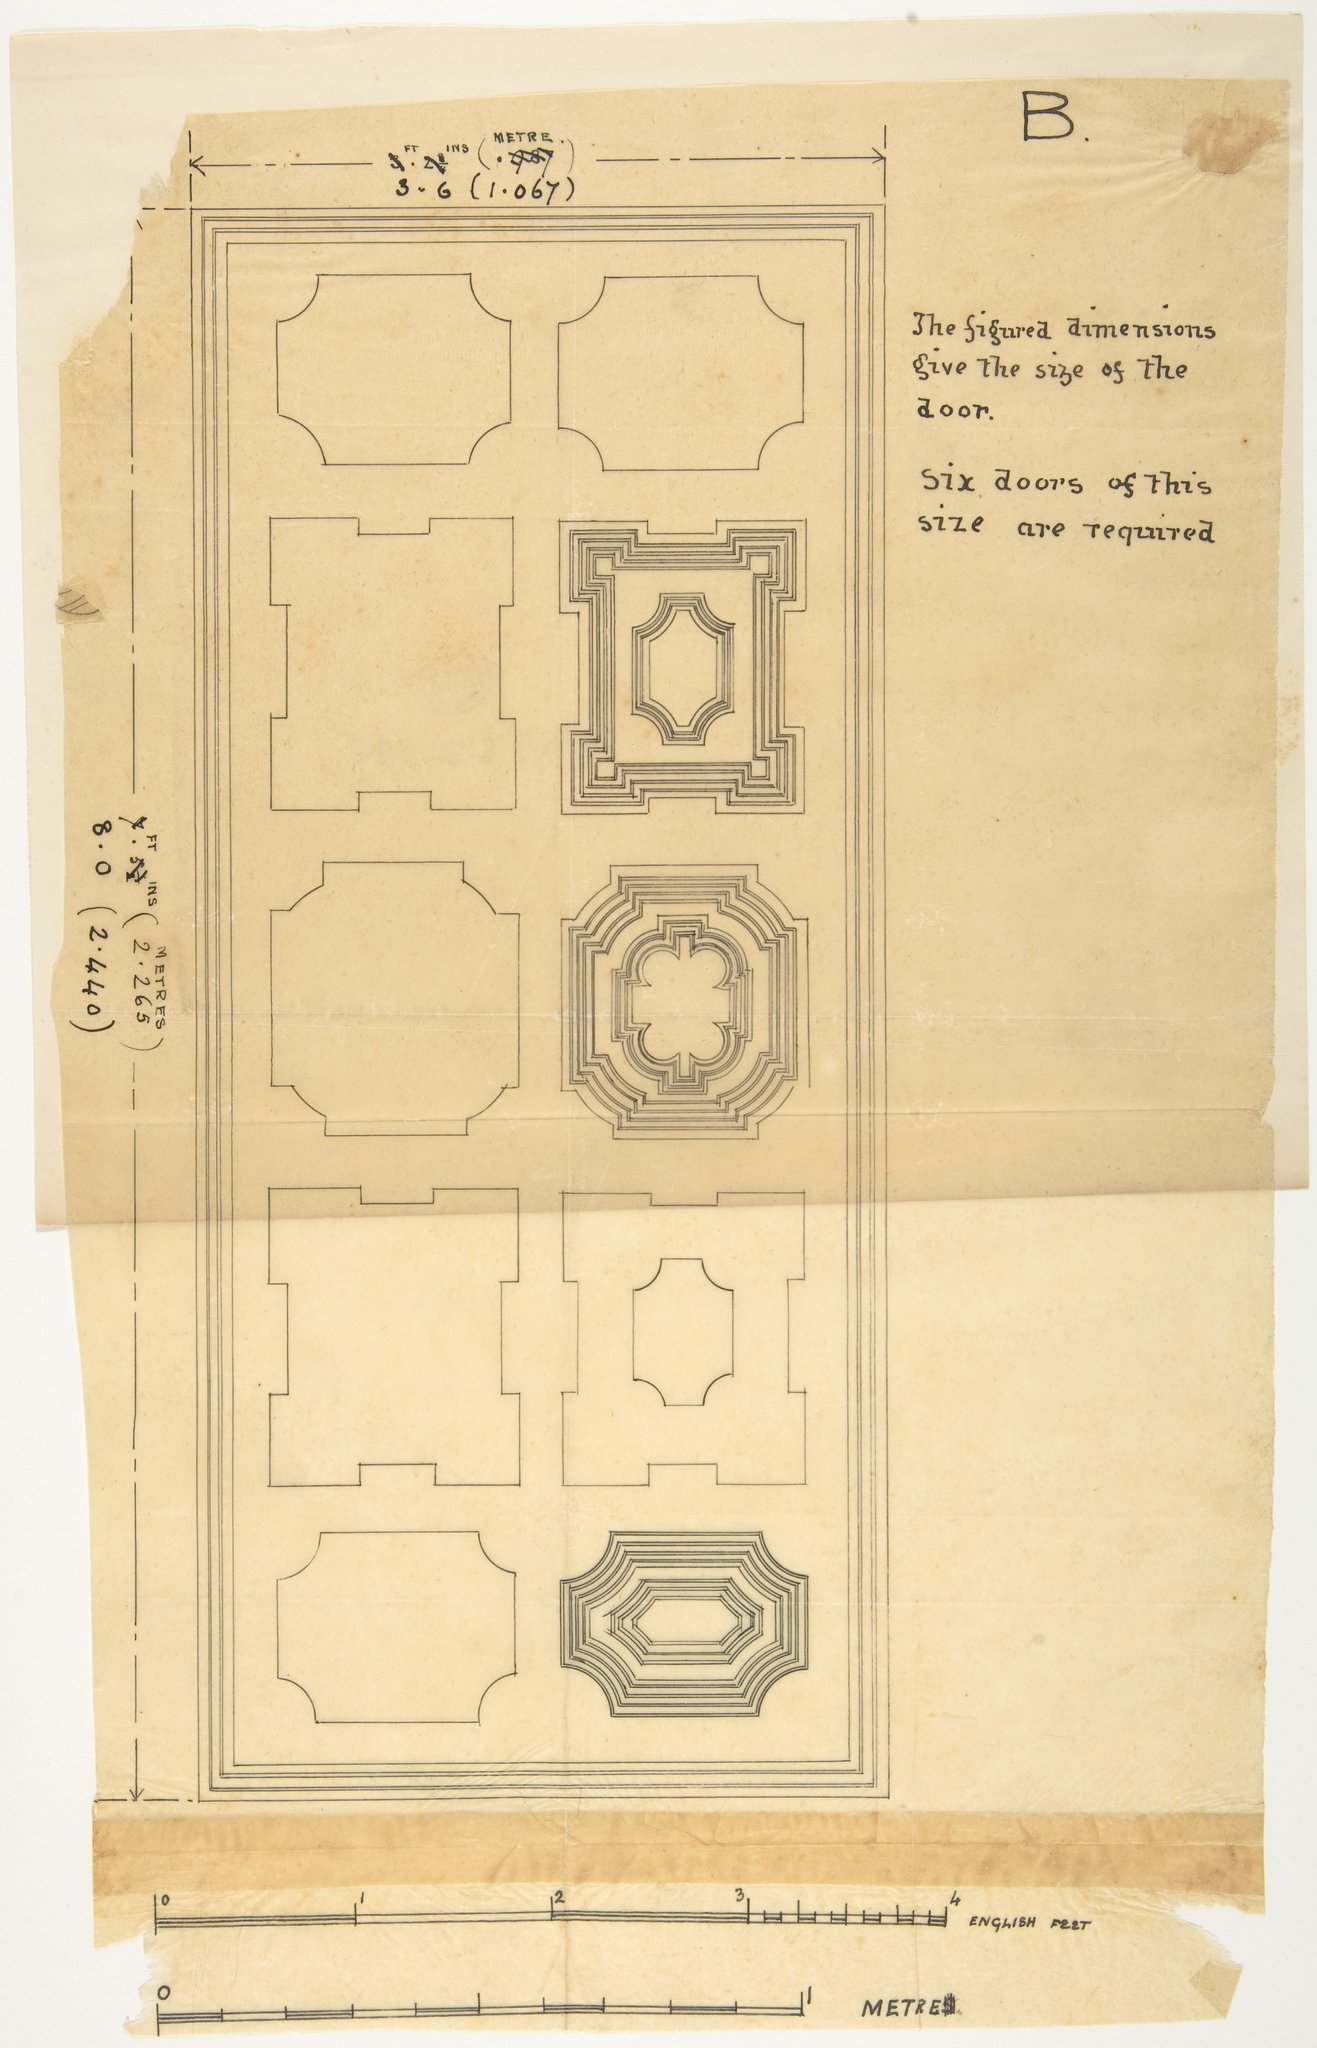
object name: drawing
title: Design for a Door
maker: anonymous, british, 19th century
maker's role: artist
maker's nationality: british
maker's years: 1800-1900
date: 1801-1900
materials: ink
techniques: pen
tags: architecture,doors